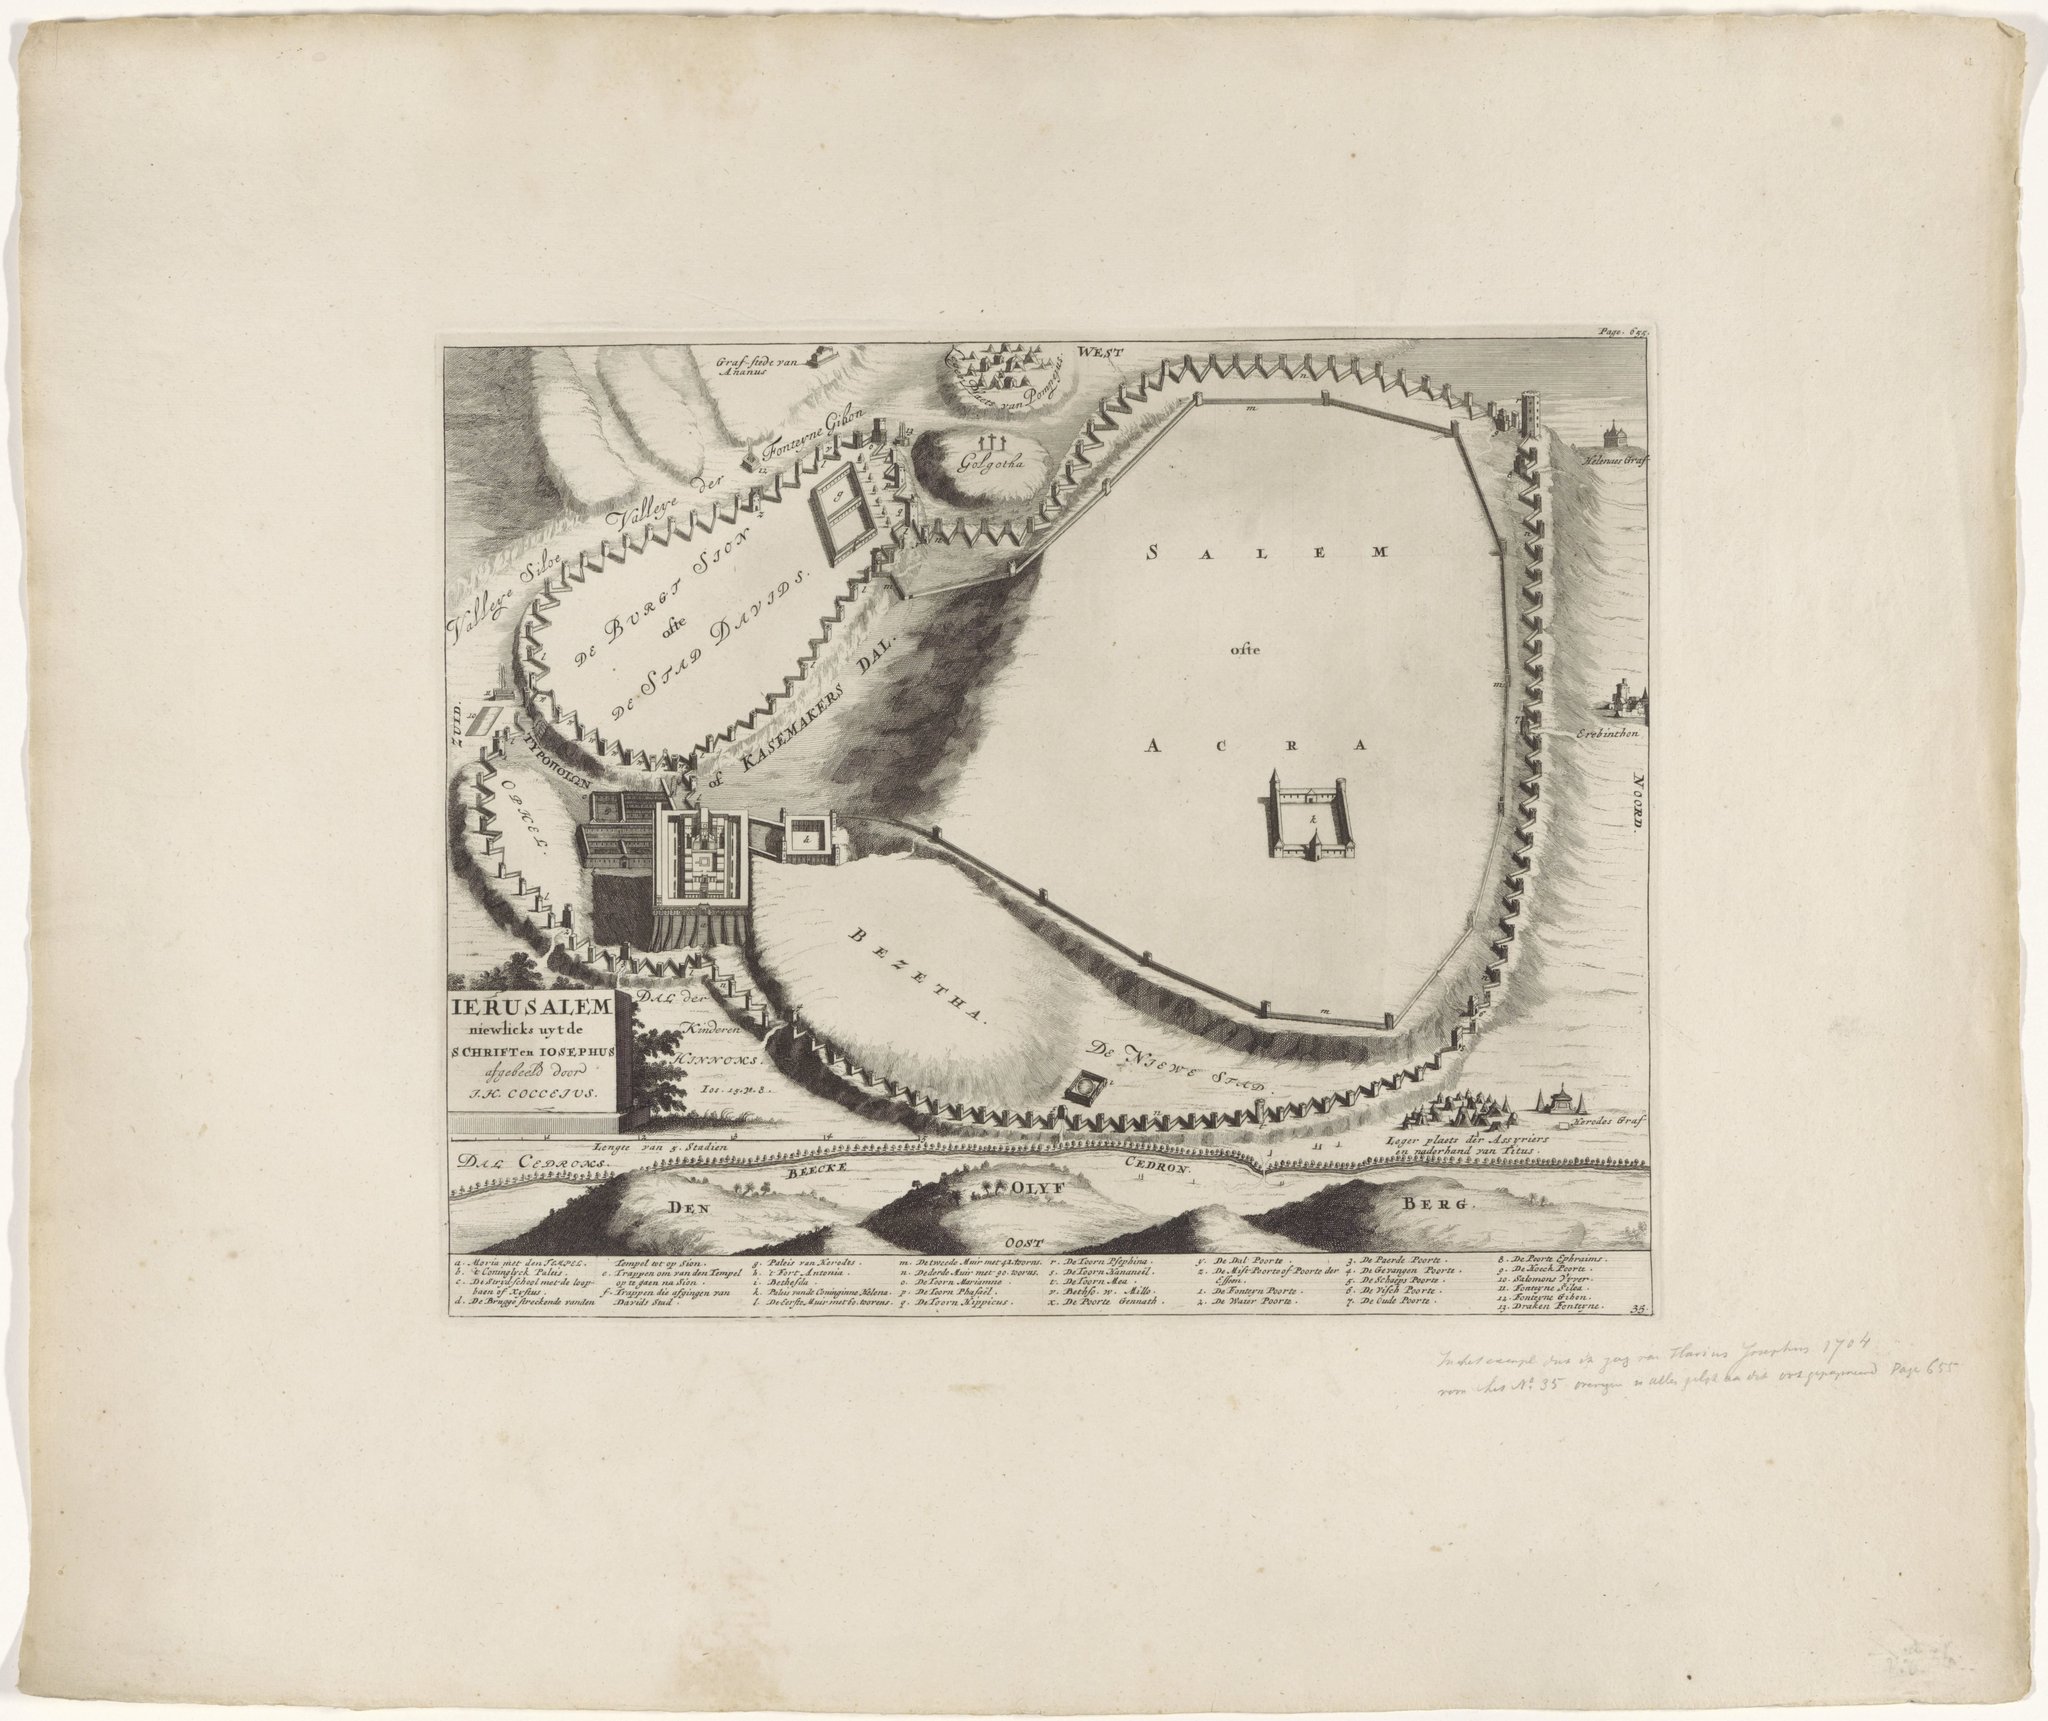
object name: print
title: Ierusalem niewlicks uyt den schriften Iosephus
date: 1704-1712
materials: paper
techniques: etching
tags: jeruzalem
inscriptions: collector's mark: Lugt 2228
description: Plattegrond van het oude Jeruzalem, gebaseerd op de boeken van Flavius Josephus. Binnen de stadsmuren zijn enkele locaties gedetailleerd weergegeven, zoals het paleis van koningin Helena, de burcht Antonia en het paleis van Herodes. Buiten de stadsmuren zijn onder andere Golgotha, de graven van Helena en Herodes en de olijfberg weergegeven.